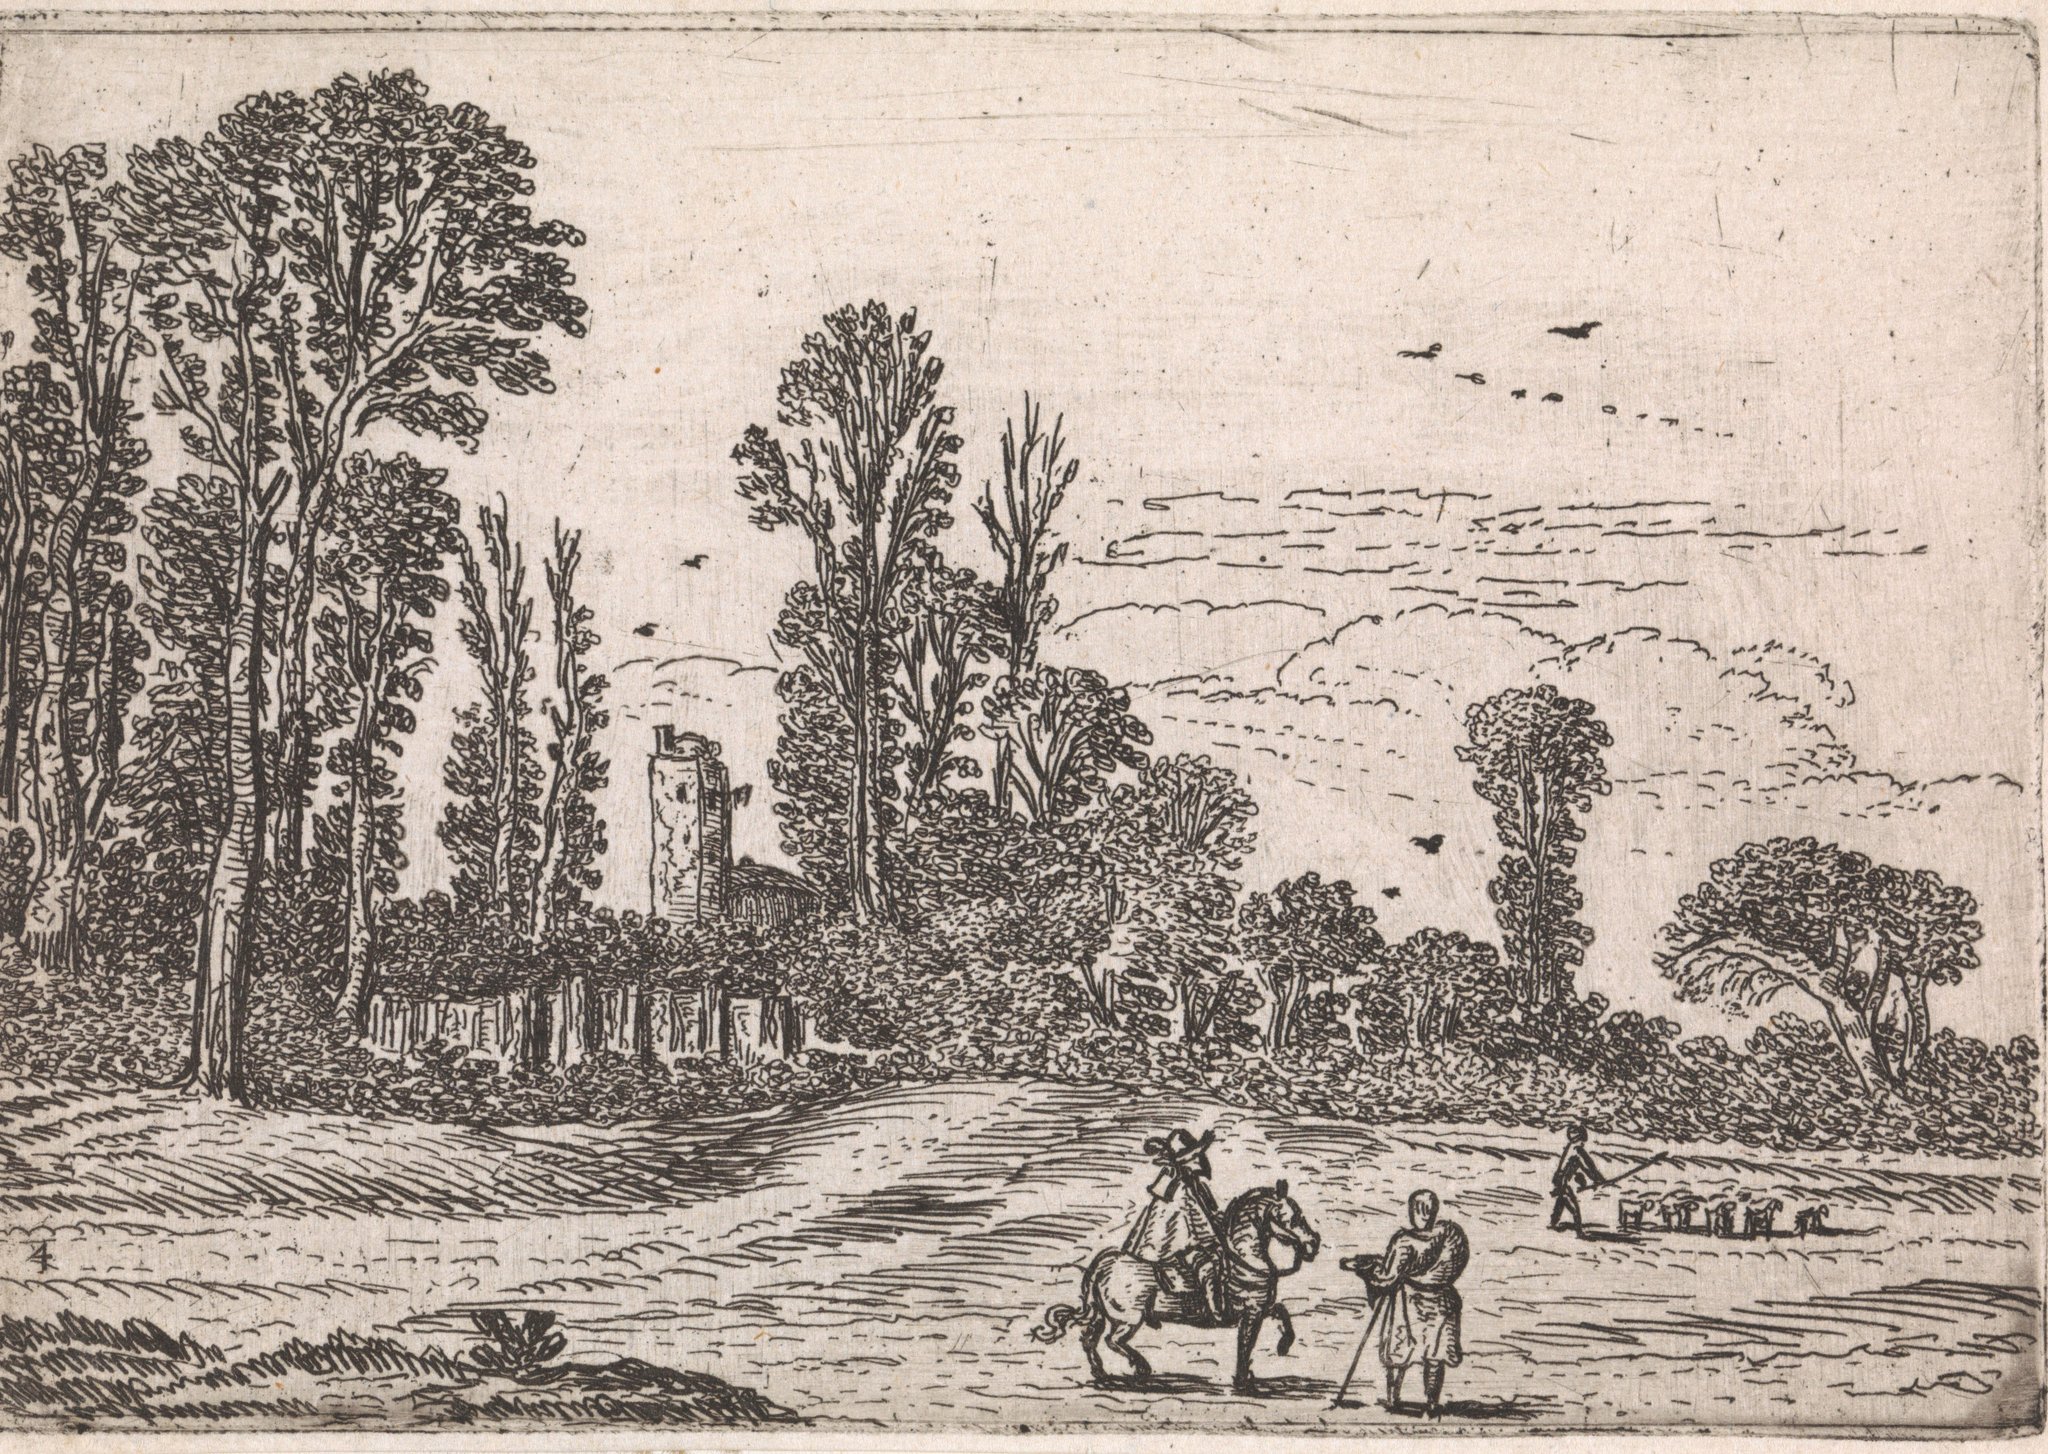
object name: print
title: Ruiter in gesprek met een staande man in een veld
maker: herman saftleven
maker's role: draughtsman, painter, print maker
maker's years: 1609-1685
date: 1627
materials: paper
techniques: etching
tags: riding a horse, ass, or mule; rider, horseman, herding, herdsman, herdswoman, shepherd, shepherdess, cowherd, etc., landscape with tower or castle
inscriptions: collector's mark: Lugt 240